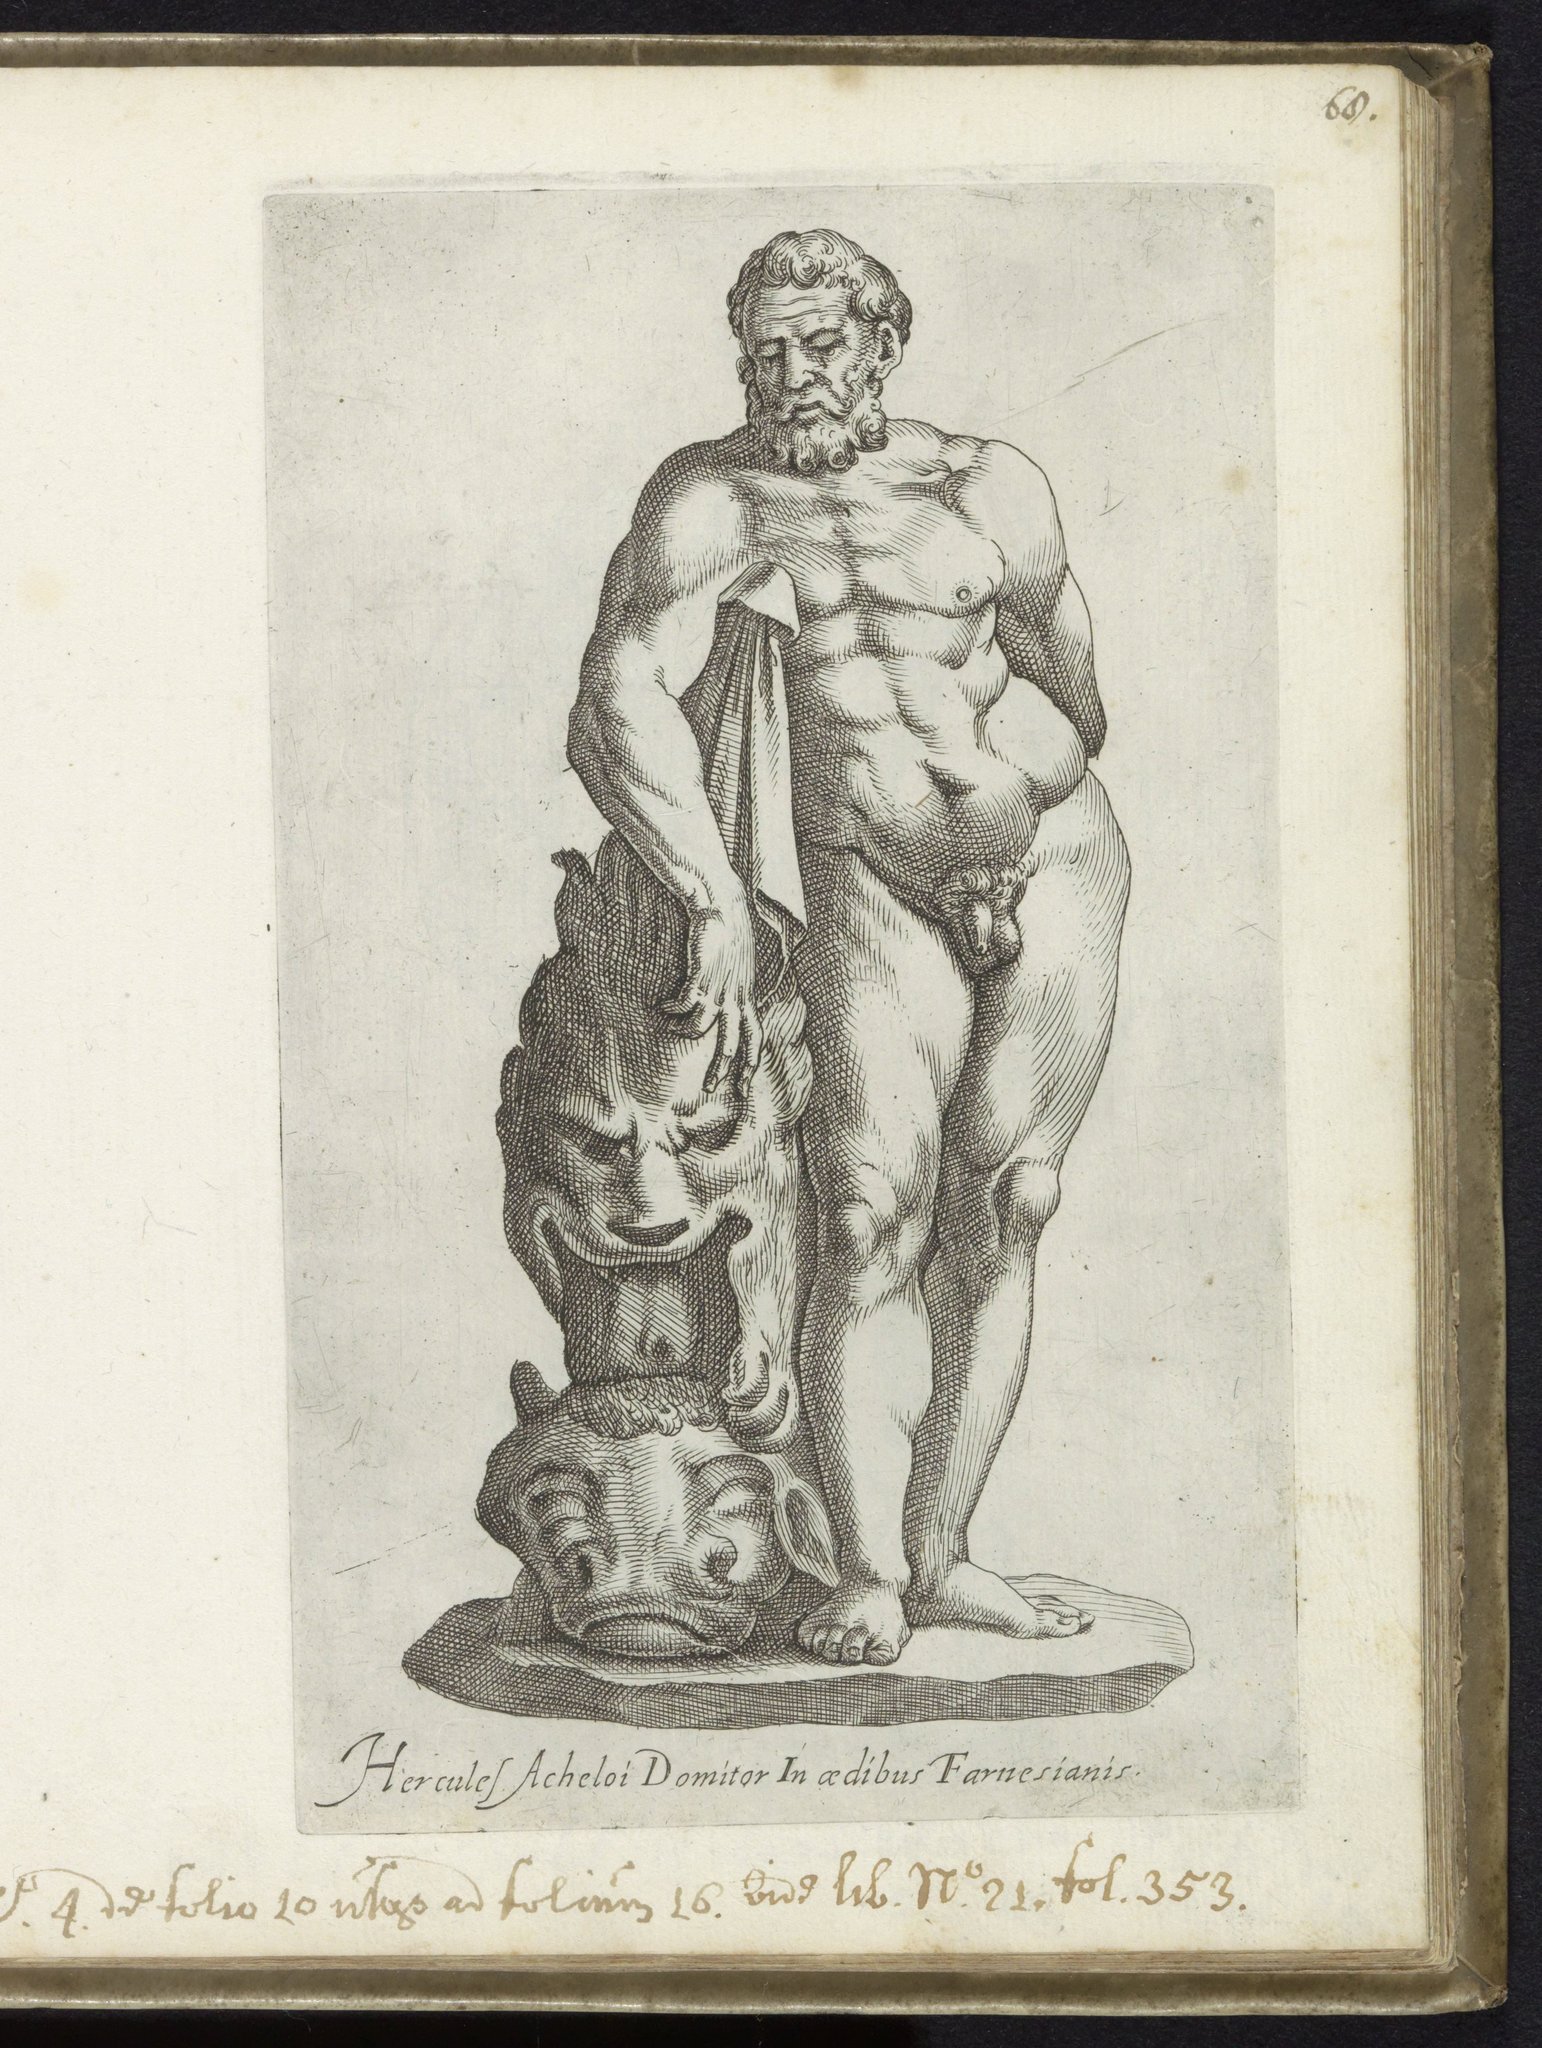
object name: album leaf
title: Sculpturen uit de oudheid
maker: Anonymous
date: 1600-1699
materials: paper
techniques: engraving, etching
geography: italy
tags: (7) the cretan bull is captured by hercules, piece of sculpture, reproduction of a piece of sculpture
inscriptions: number: ‘68’, inscription: ‘Ende lib. No. 23. fol. 460. Ende lib. No. 20 fol. 43. 49 et lib. No. 4 [...] folio 20 [...] 16. Ende lib. No. 21. fol. 353’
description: Deze prent maakt deel uit van een reeks van ten minste 50 prenten van sculpturen uit de oudheid.